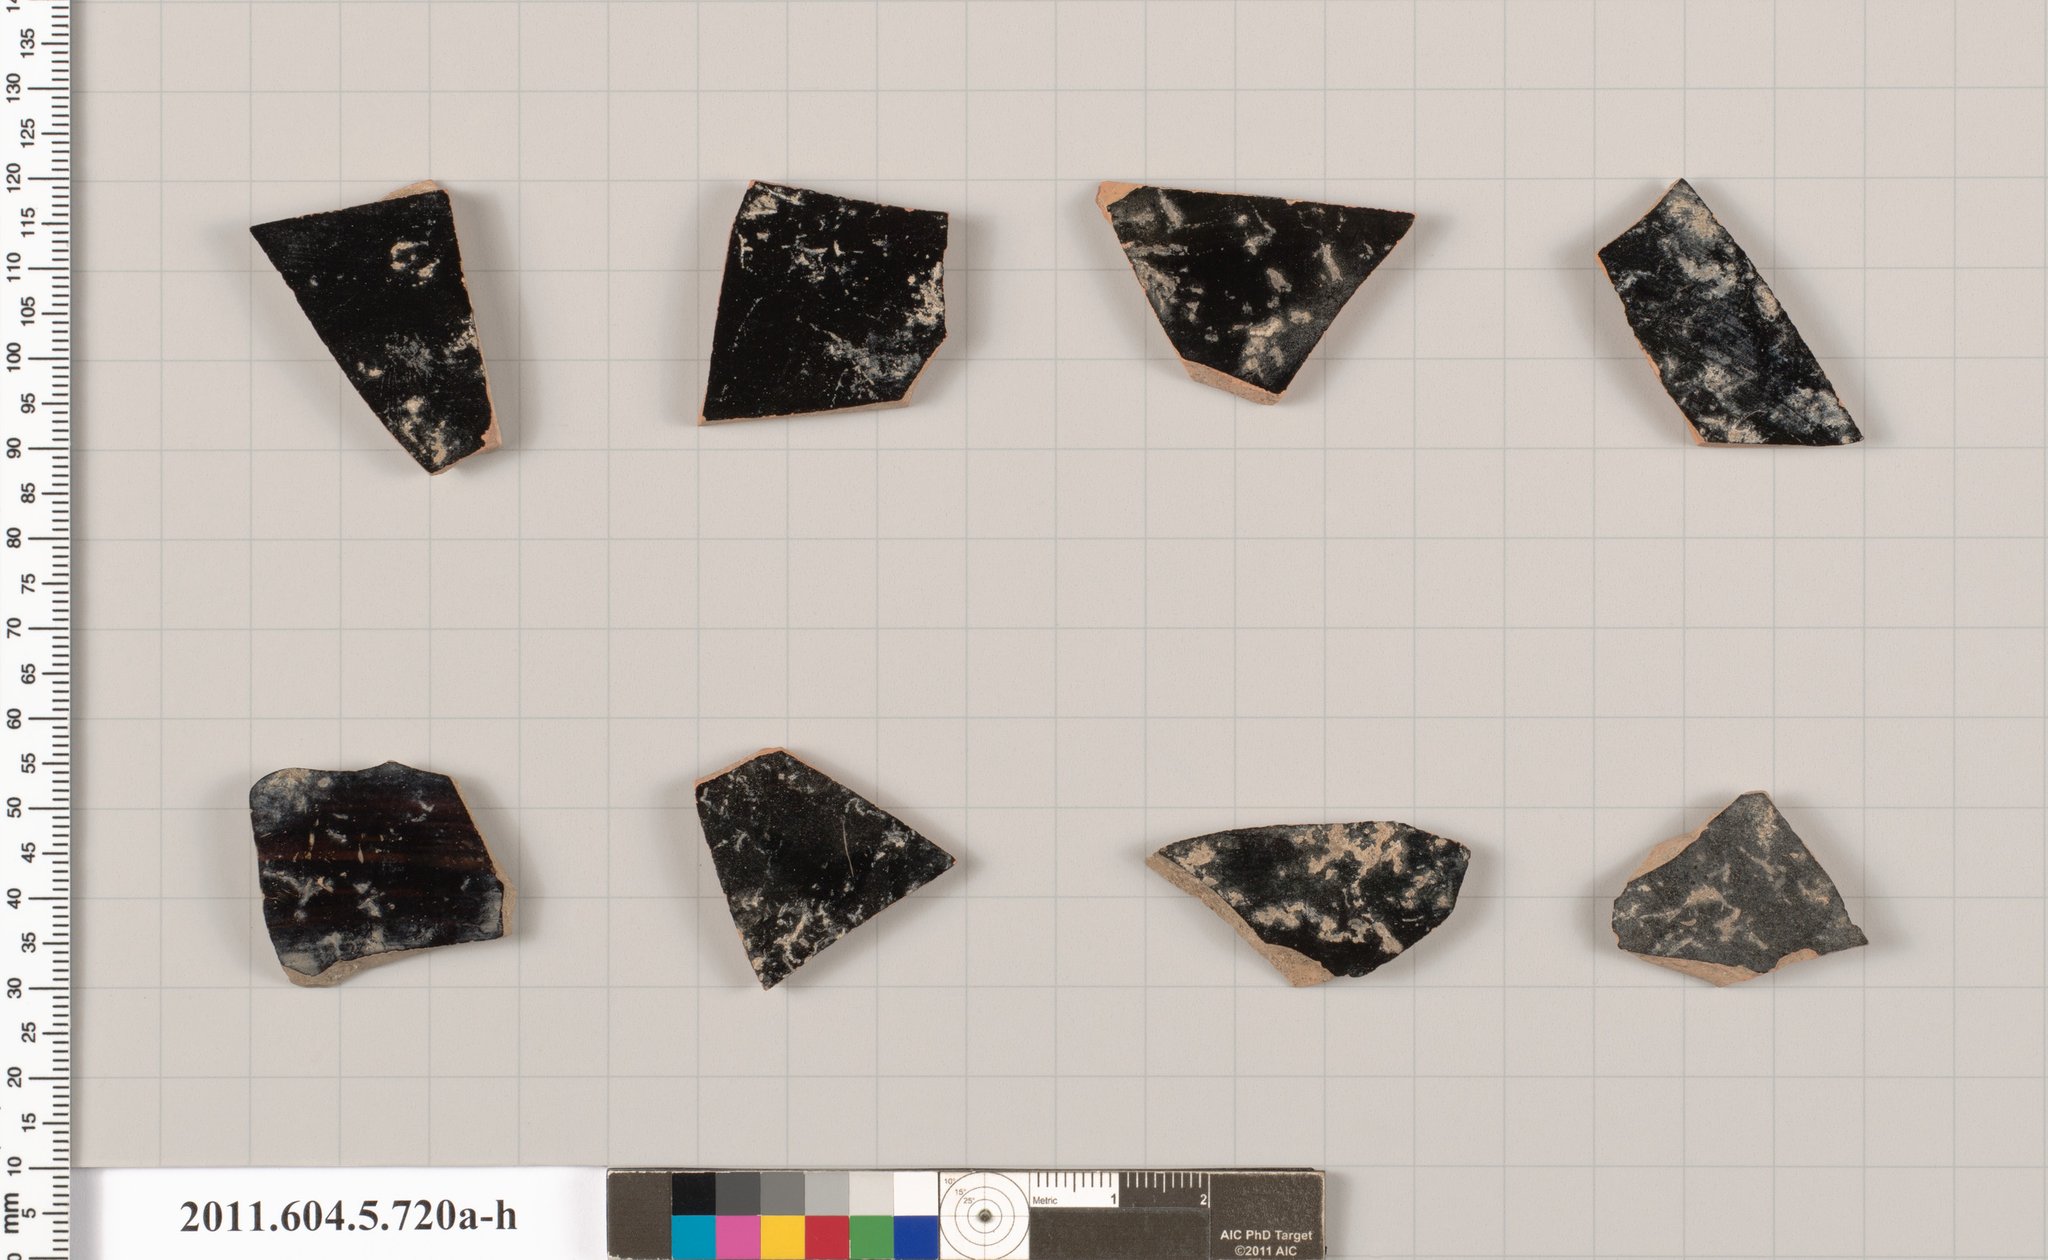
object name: kylix fragment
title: Terracotta fragments of kylikes (drinking cups)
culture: greek, attic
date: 600-401 BCE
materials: terracotta